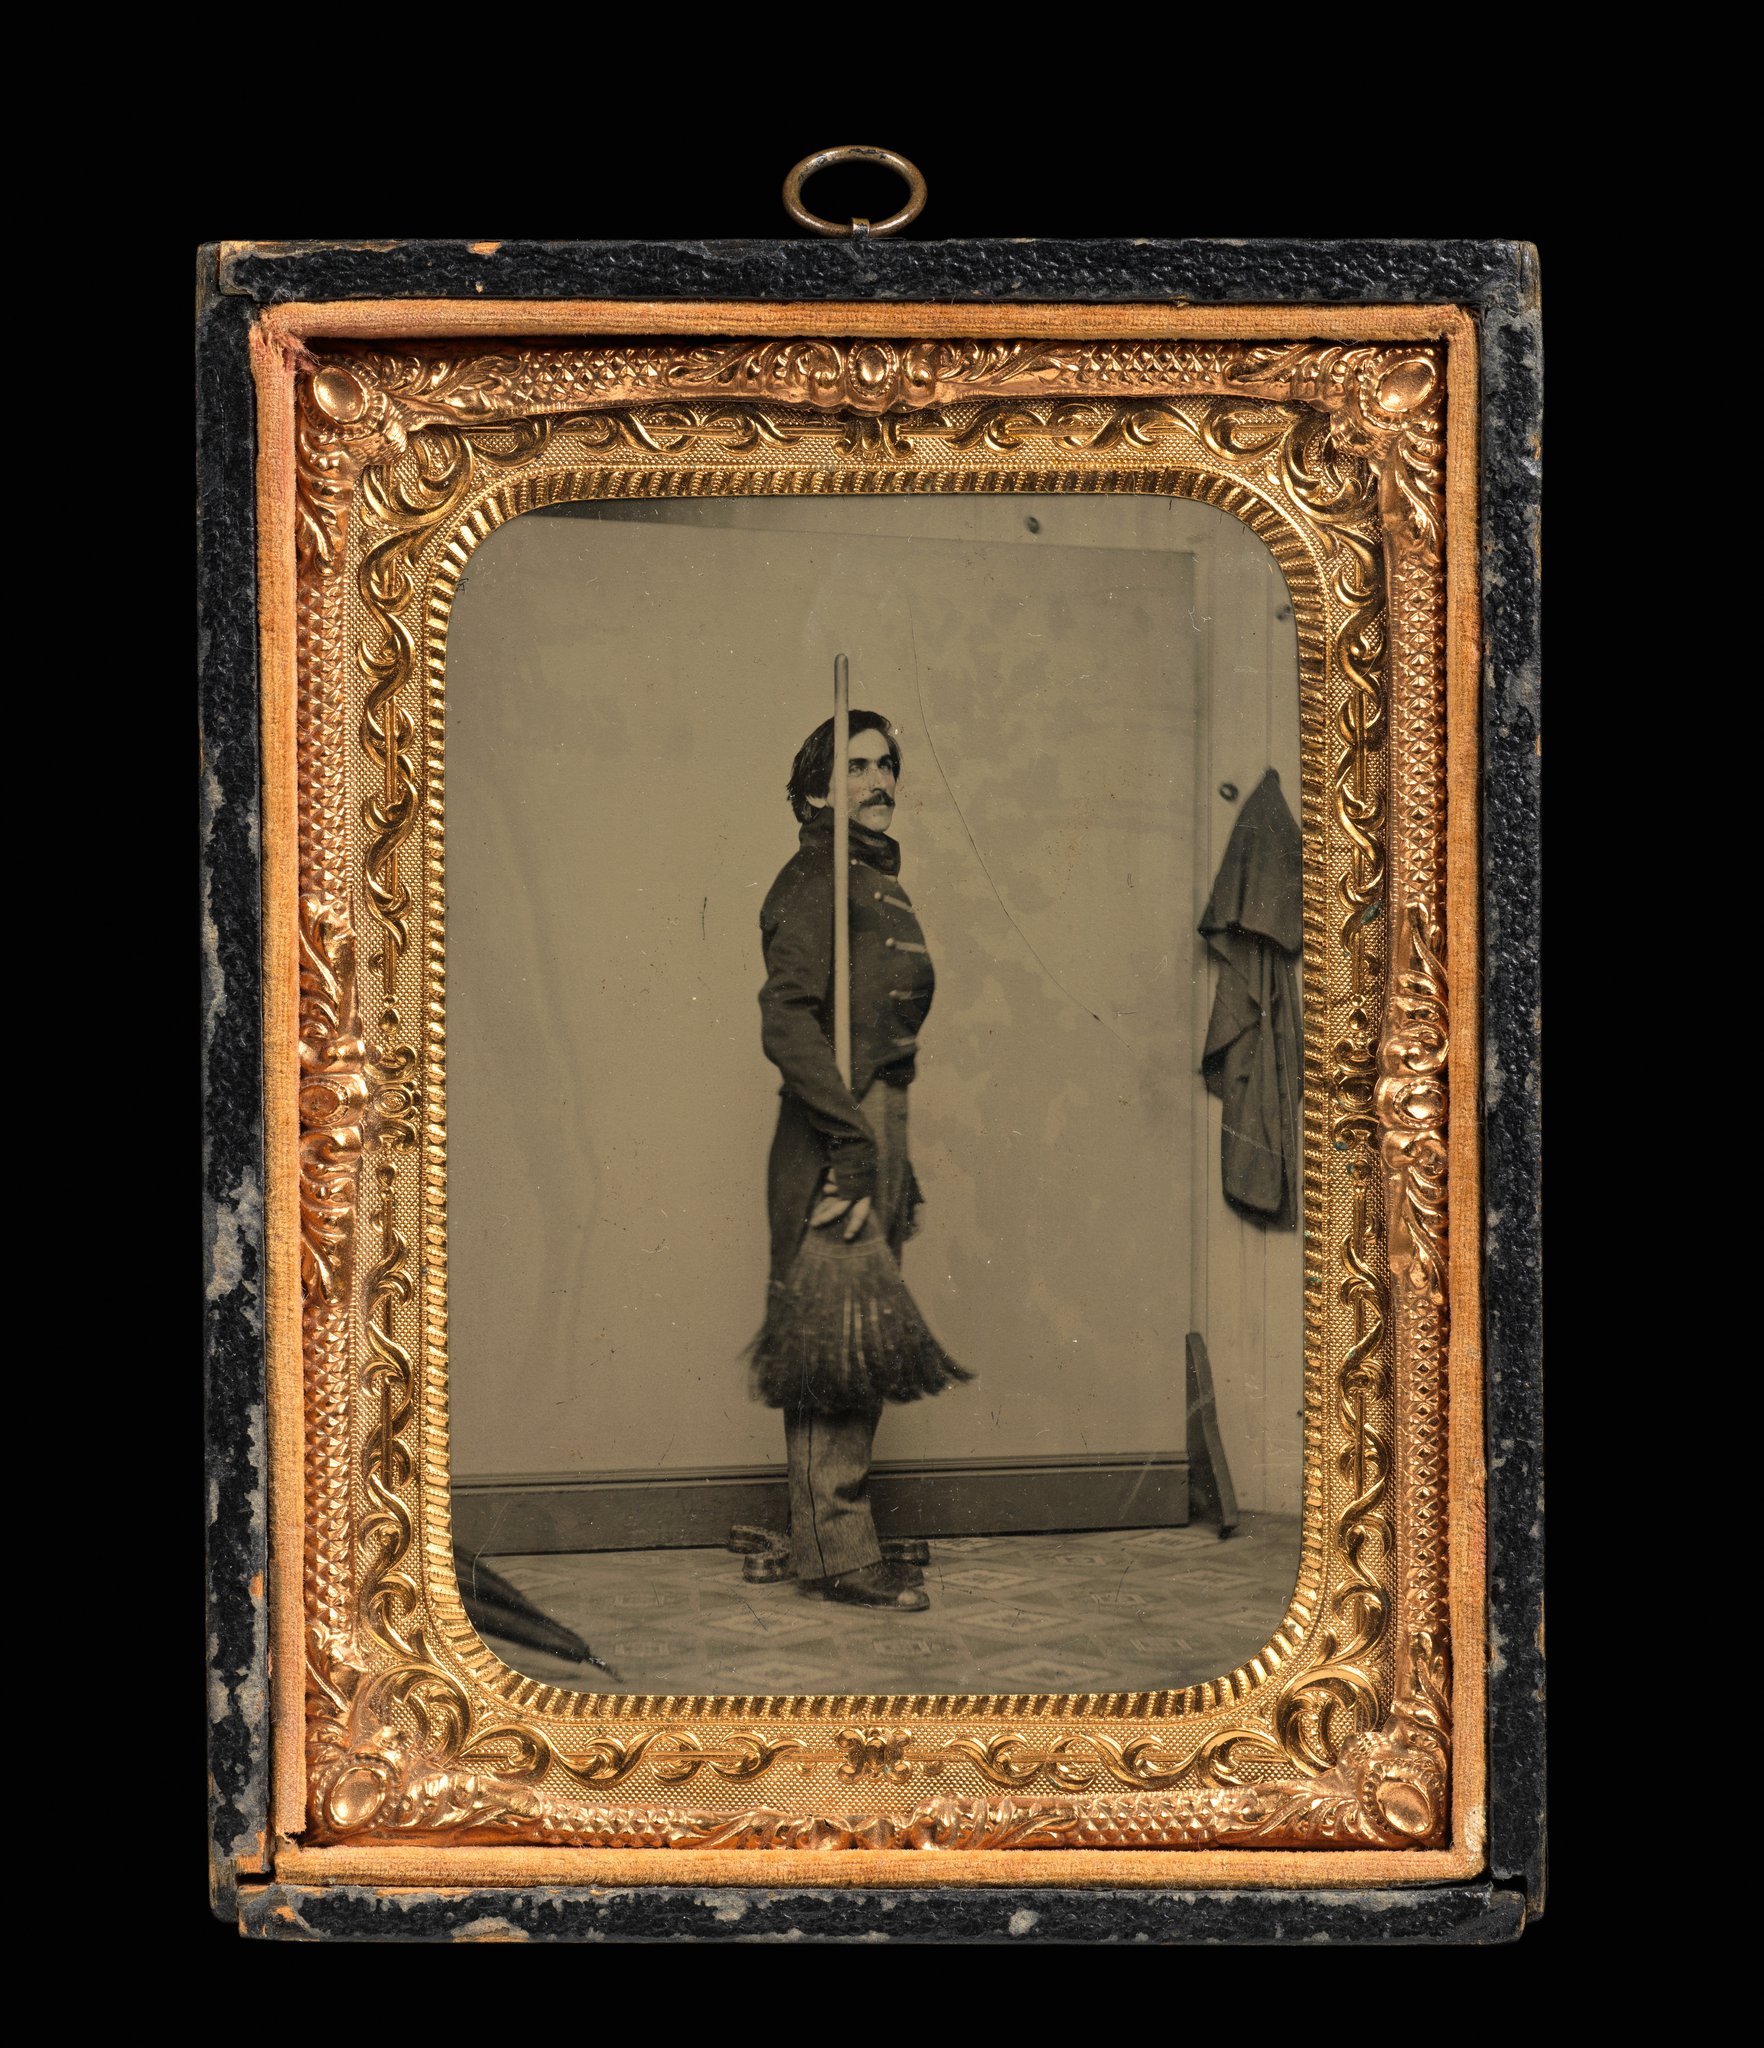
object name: tintype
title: [Union Civil War Soldier Posed in Studio with Broom in Place of Rifle]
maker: Anonymous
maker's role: artist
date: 1860-1869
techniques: tintype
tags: soldiers,american civil war,brooms